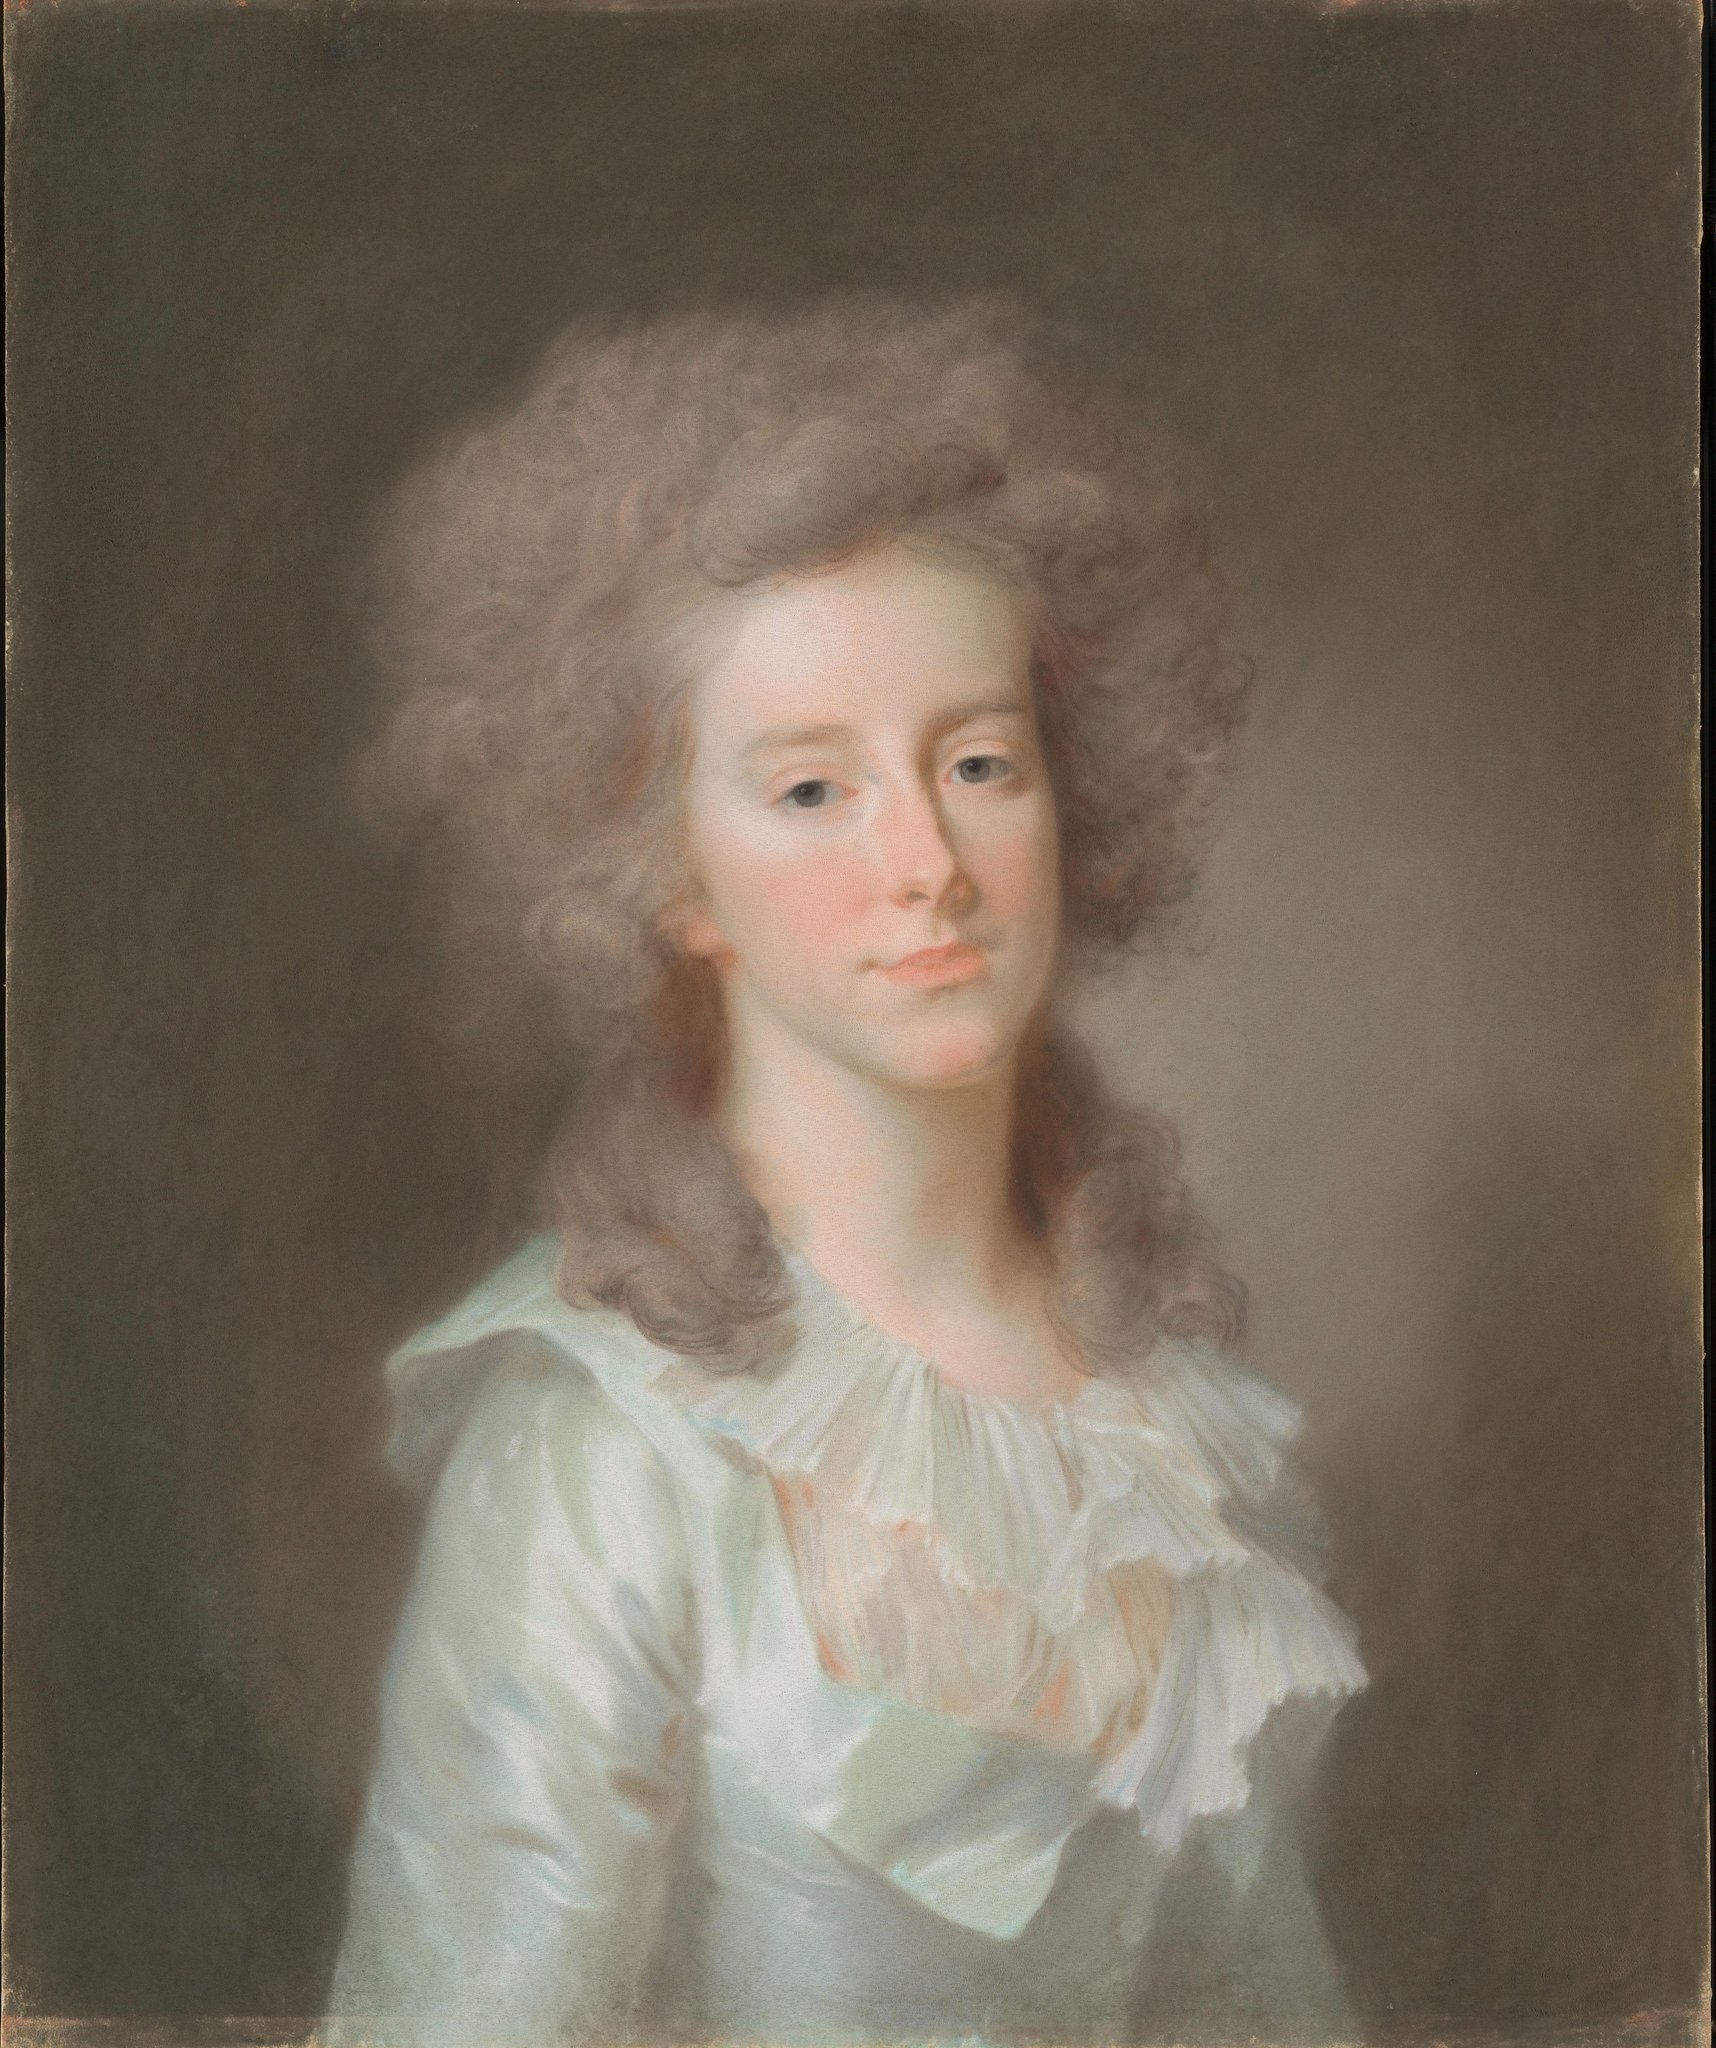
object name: drawing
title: Frederica Louise Wilhelmina, Princess of Orange-Nassau (Daughter of William V)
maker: johann friedrich august tischbein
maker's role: painter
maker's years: 1750-1812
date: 1785-1795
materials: parchment, pastel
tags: karel van brunswijk-wolfenbüttel, the hague, louise (prinses van oranje-nassau), historical persons - bb - woman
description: Under pressure from fierce opposition to his rule, Stadtholder William V and his family fled The Hague in 1785. They returned two years later and the stadtholder’s authority was restored. This provided the occasion to commission a series of portraits of the members of his family from the portraitist Tischbein. The artist produced a fashionable group of oval portraits in pastel. The giltwood frames were made by the Hague framemaker Hendrik Ebbens.